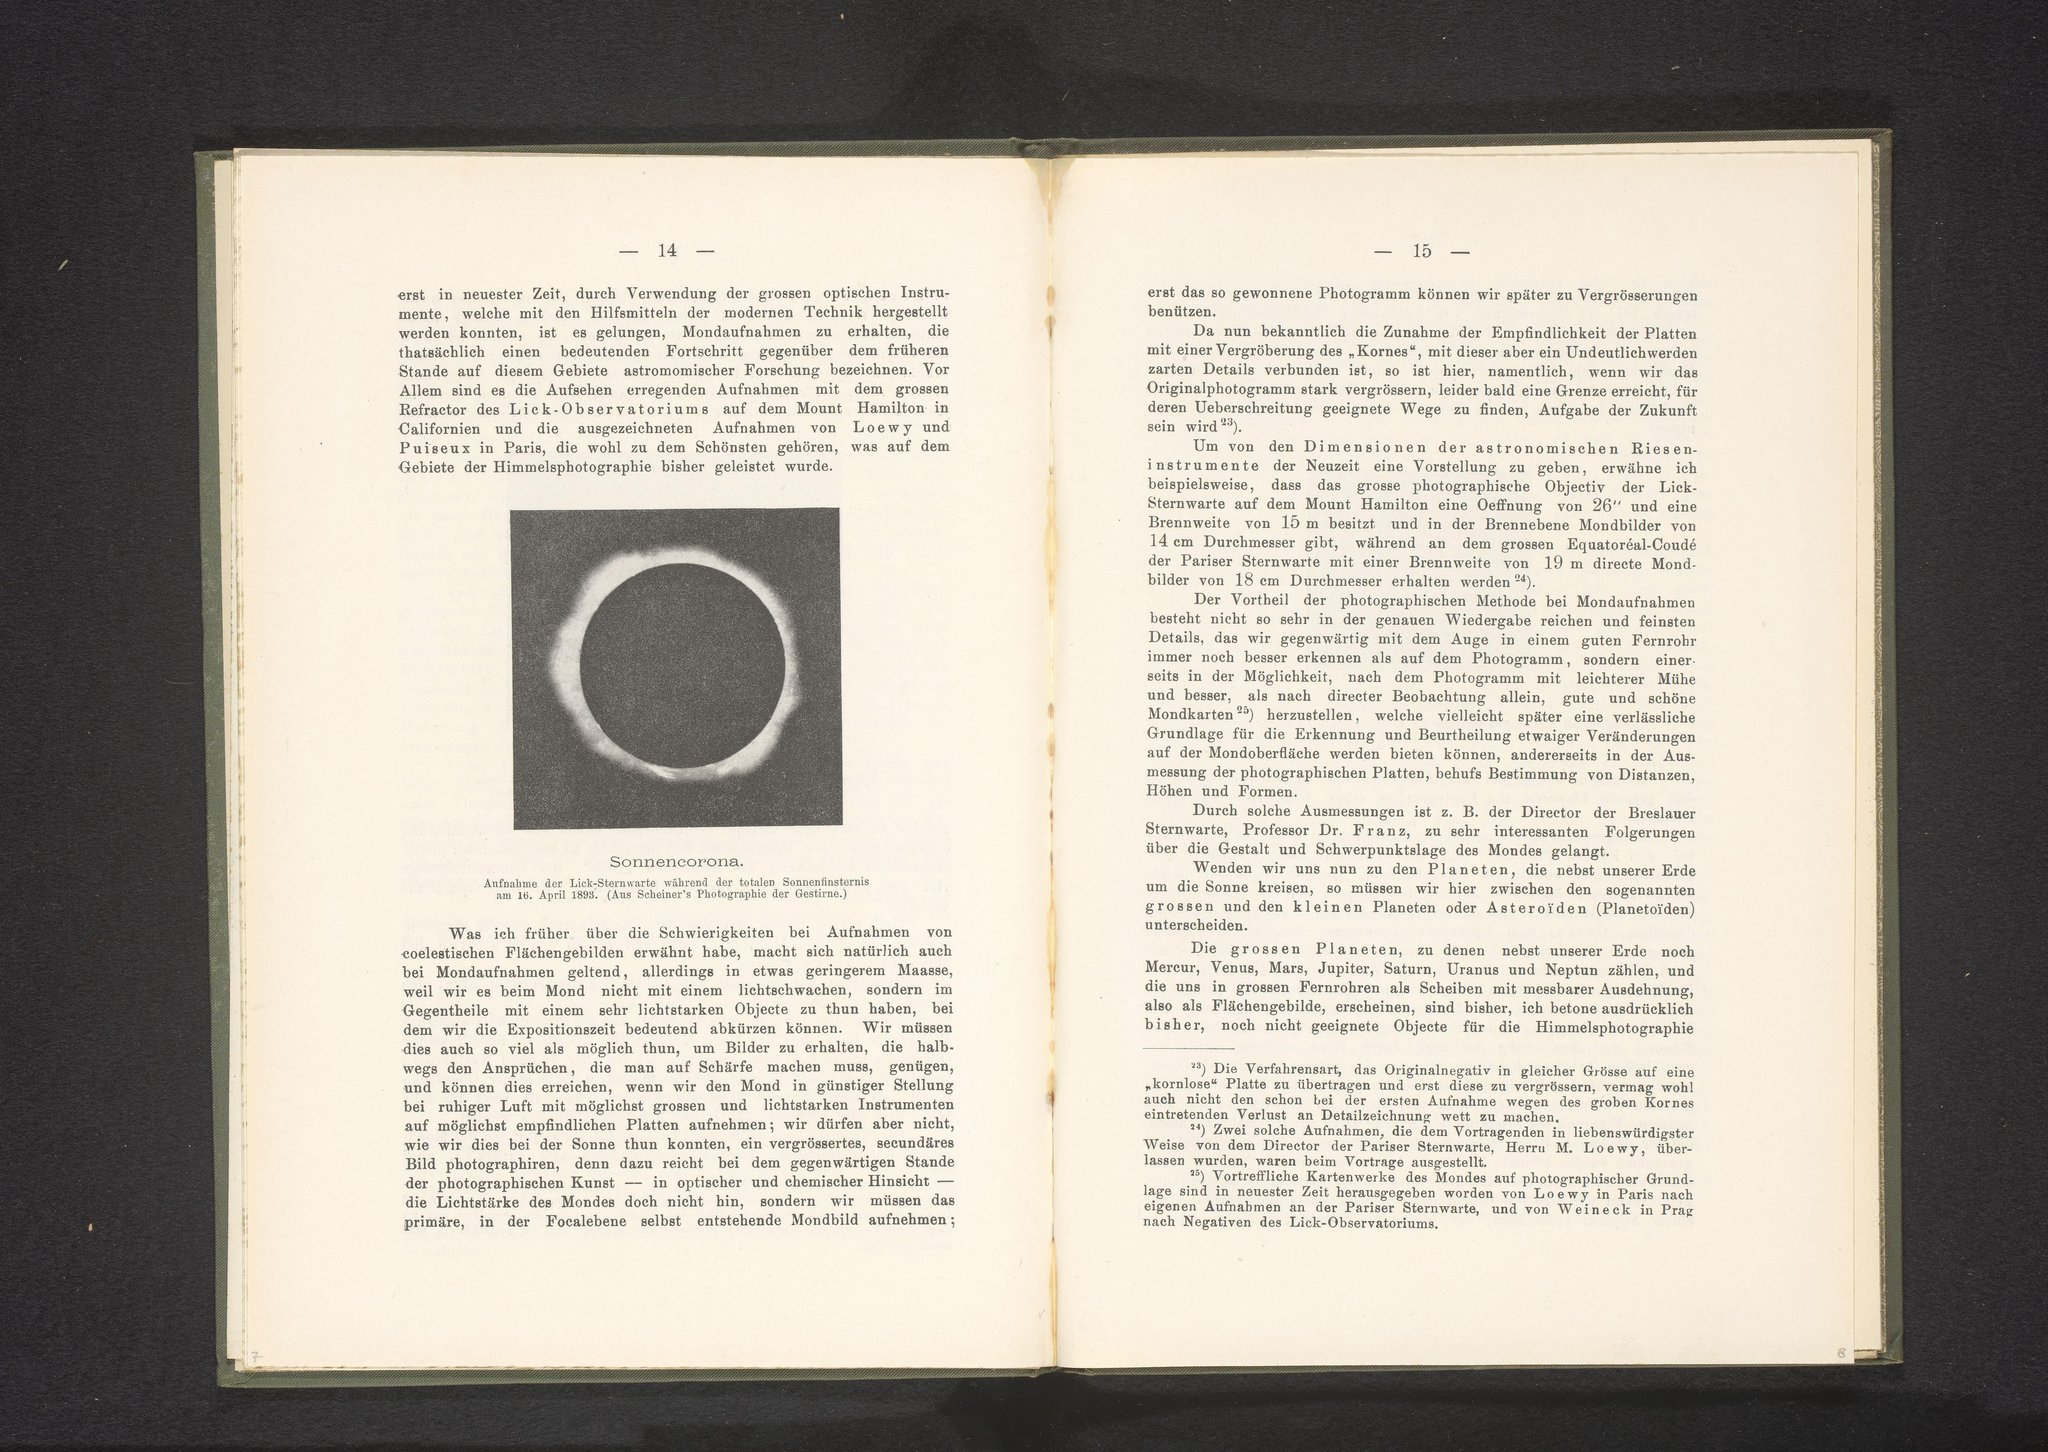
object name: page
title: Corona rond de zon tijdens een zonsverduistering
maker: Anonymous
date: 1893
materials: paper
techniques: autotype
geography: lick observatory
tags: total solar eclipse with corona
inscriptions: inscription: ‘Aufnahme der Lick-Sternwarte während der totalen Sonnenfinsternis am 16. April 1893. (Aus Scheiner's Photographie der Gestirne.)’